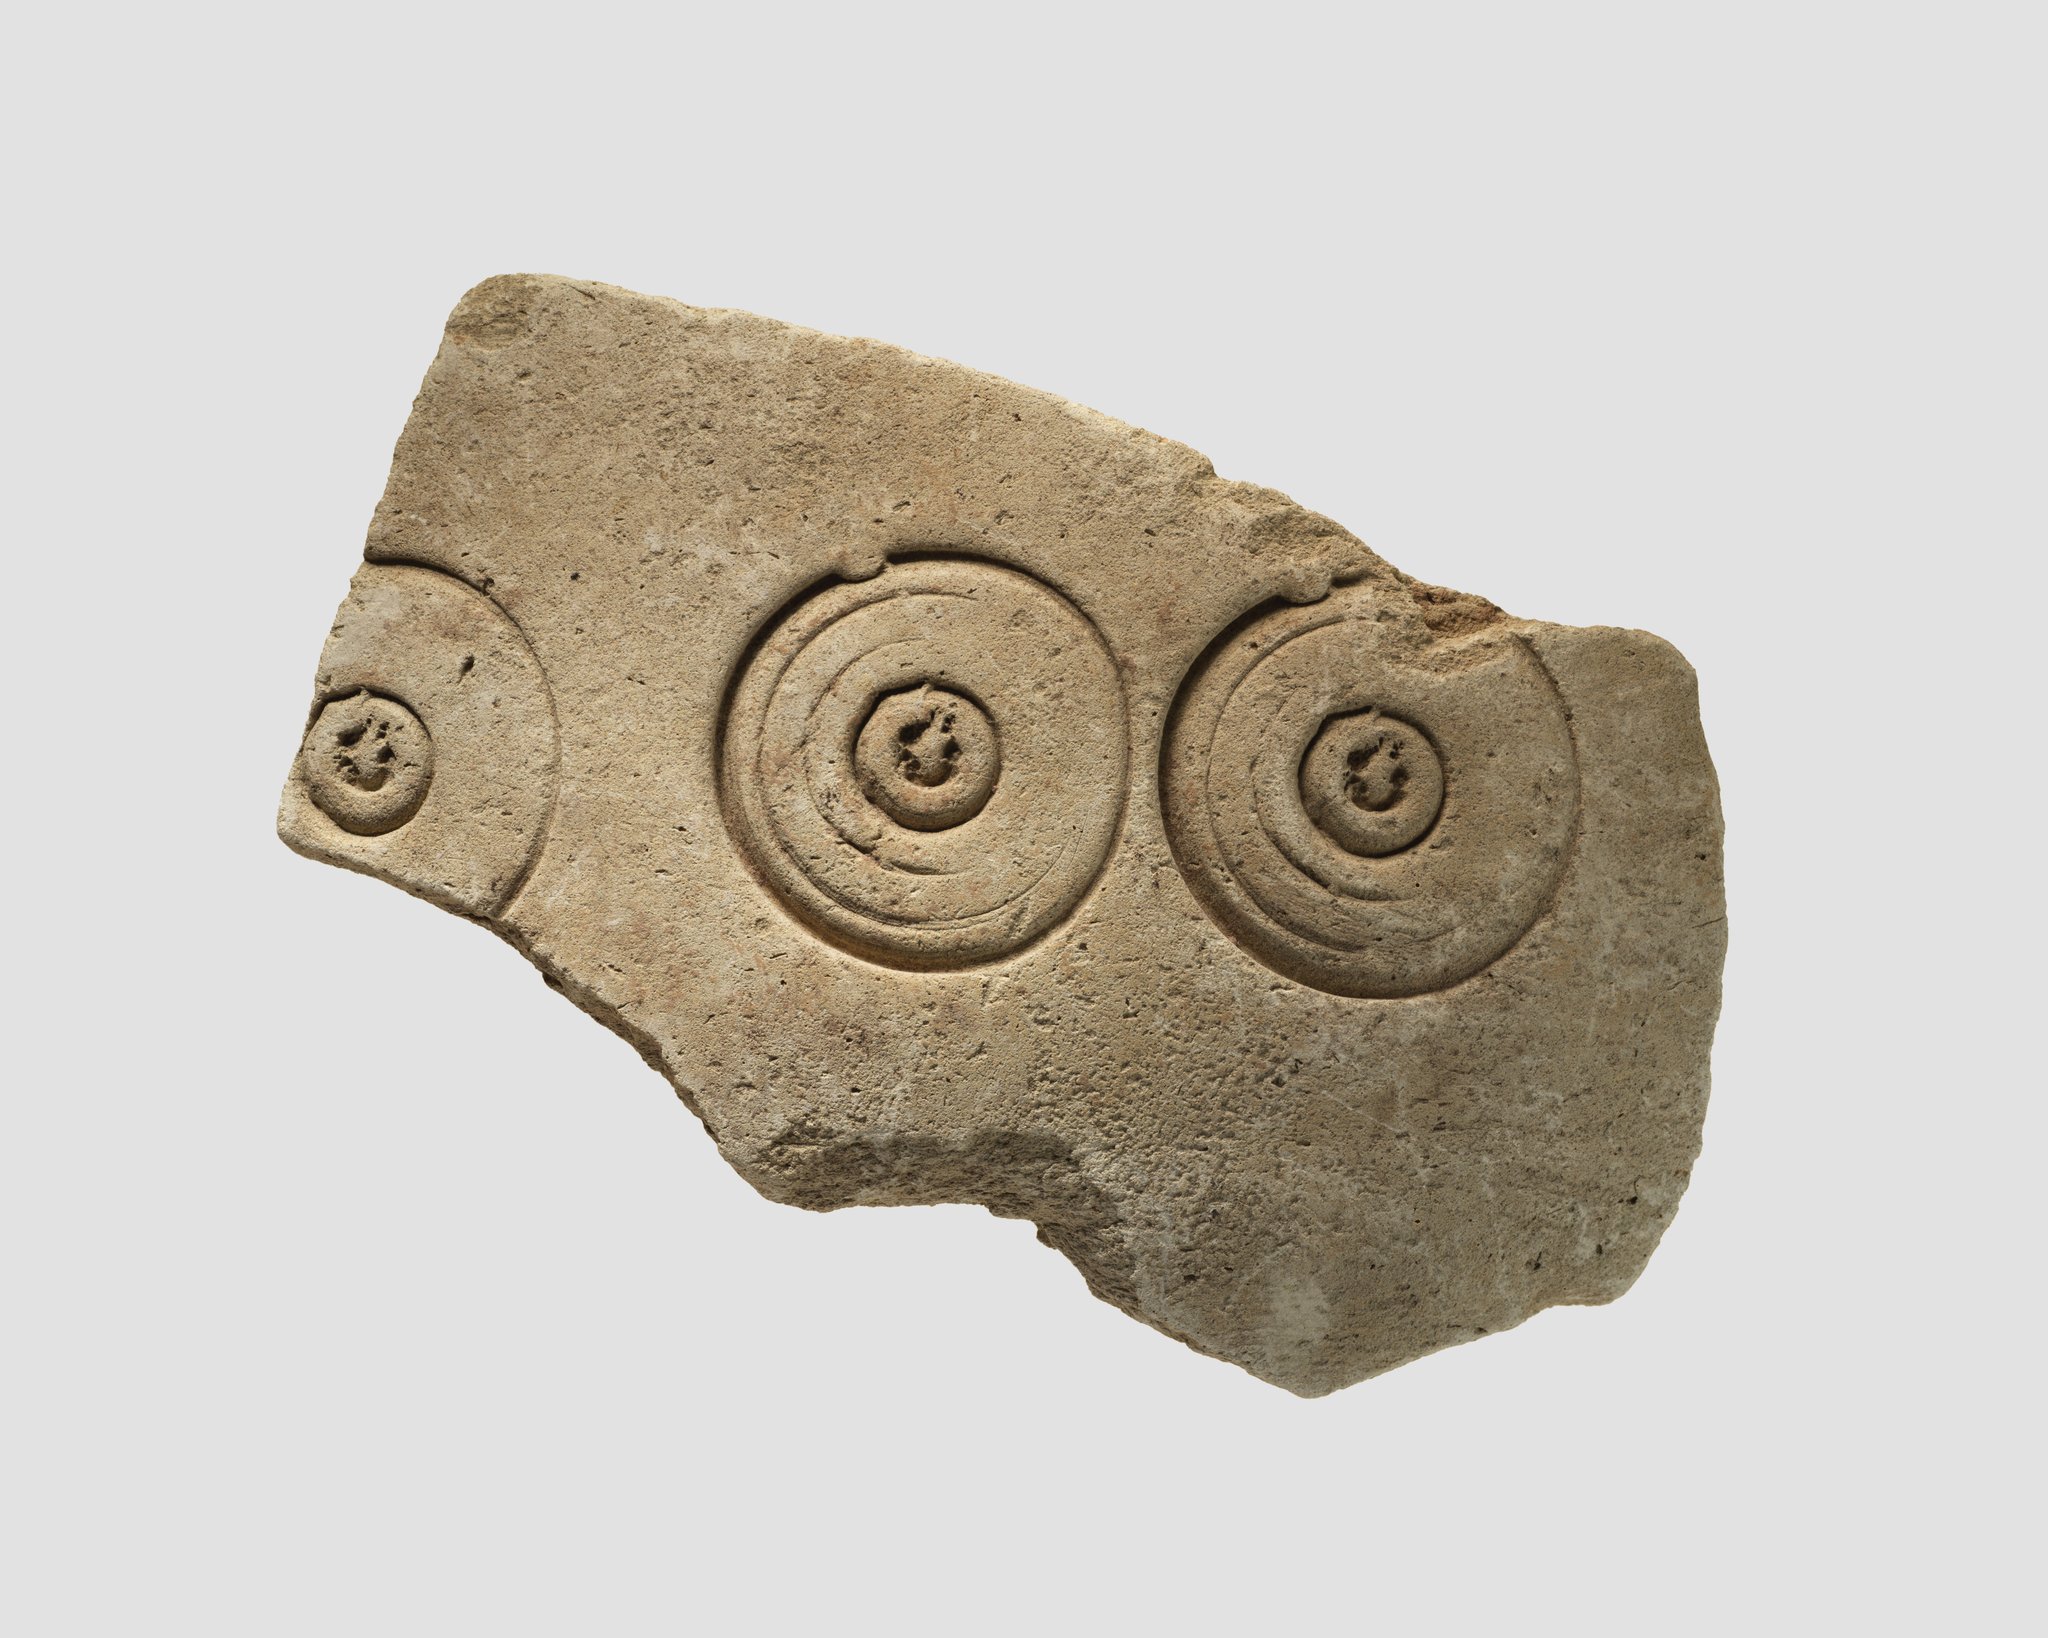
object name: sherd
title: Sherds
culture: sasanian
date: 201-700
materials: ceramic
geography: mesopotamia